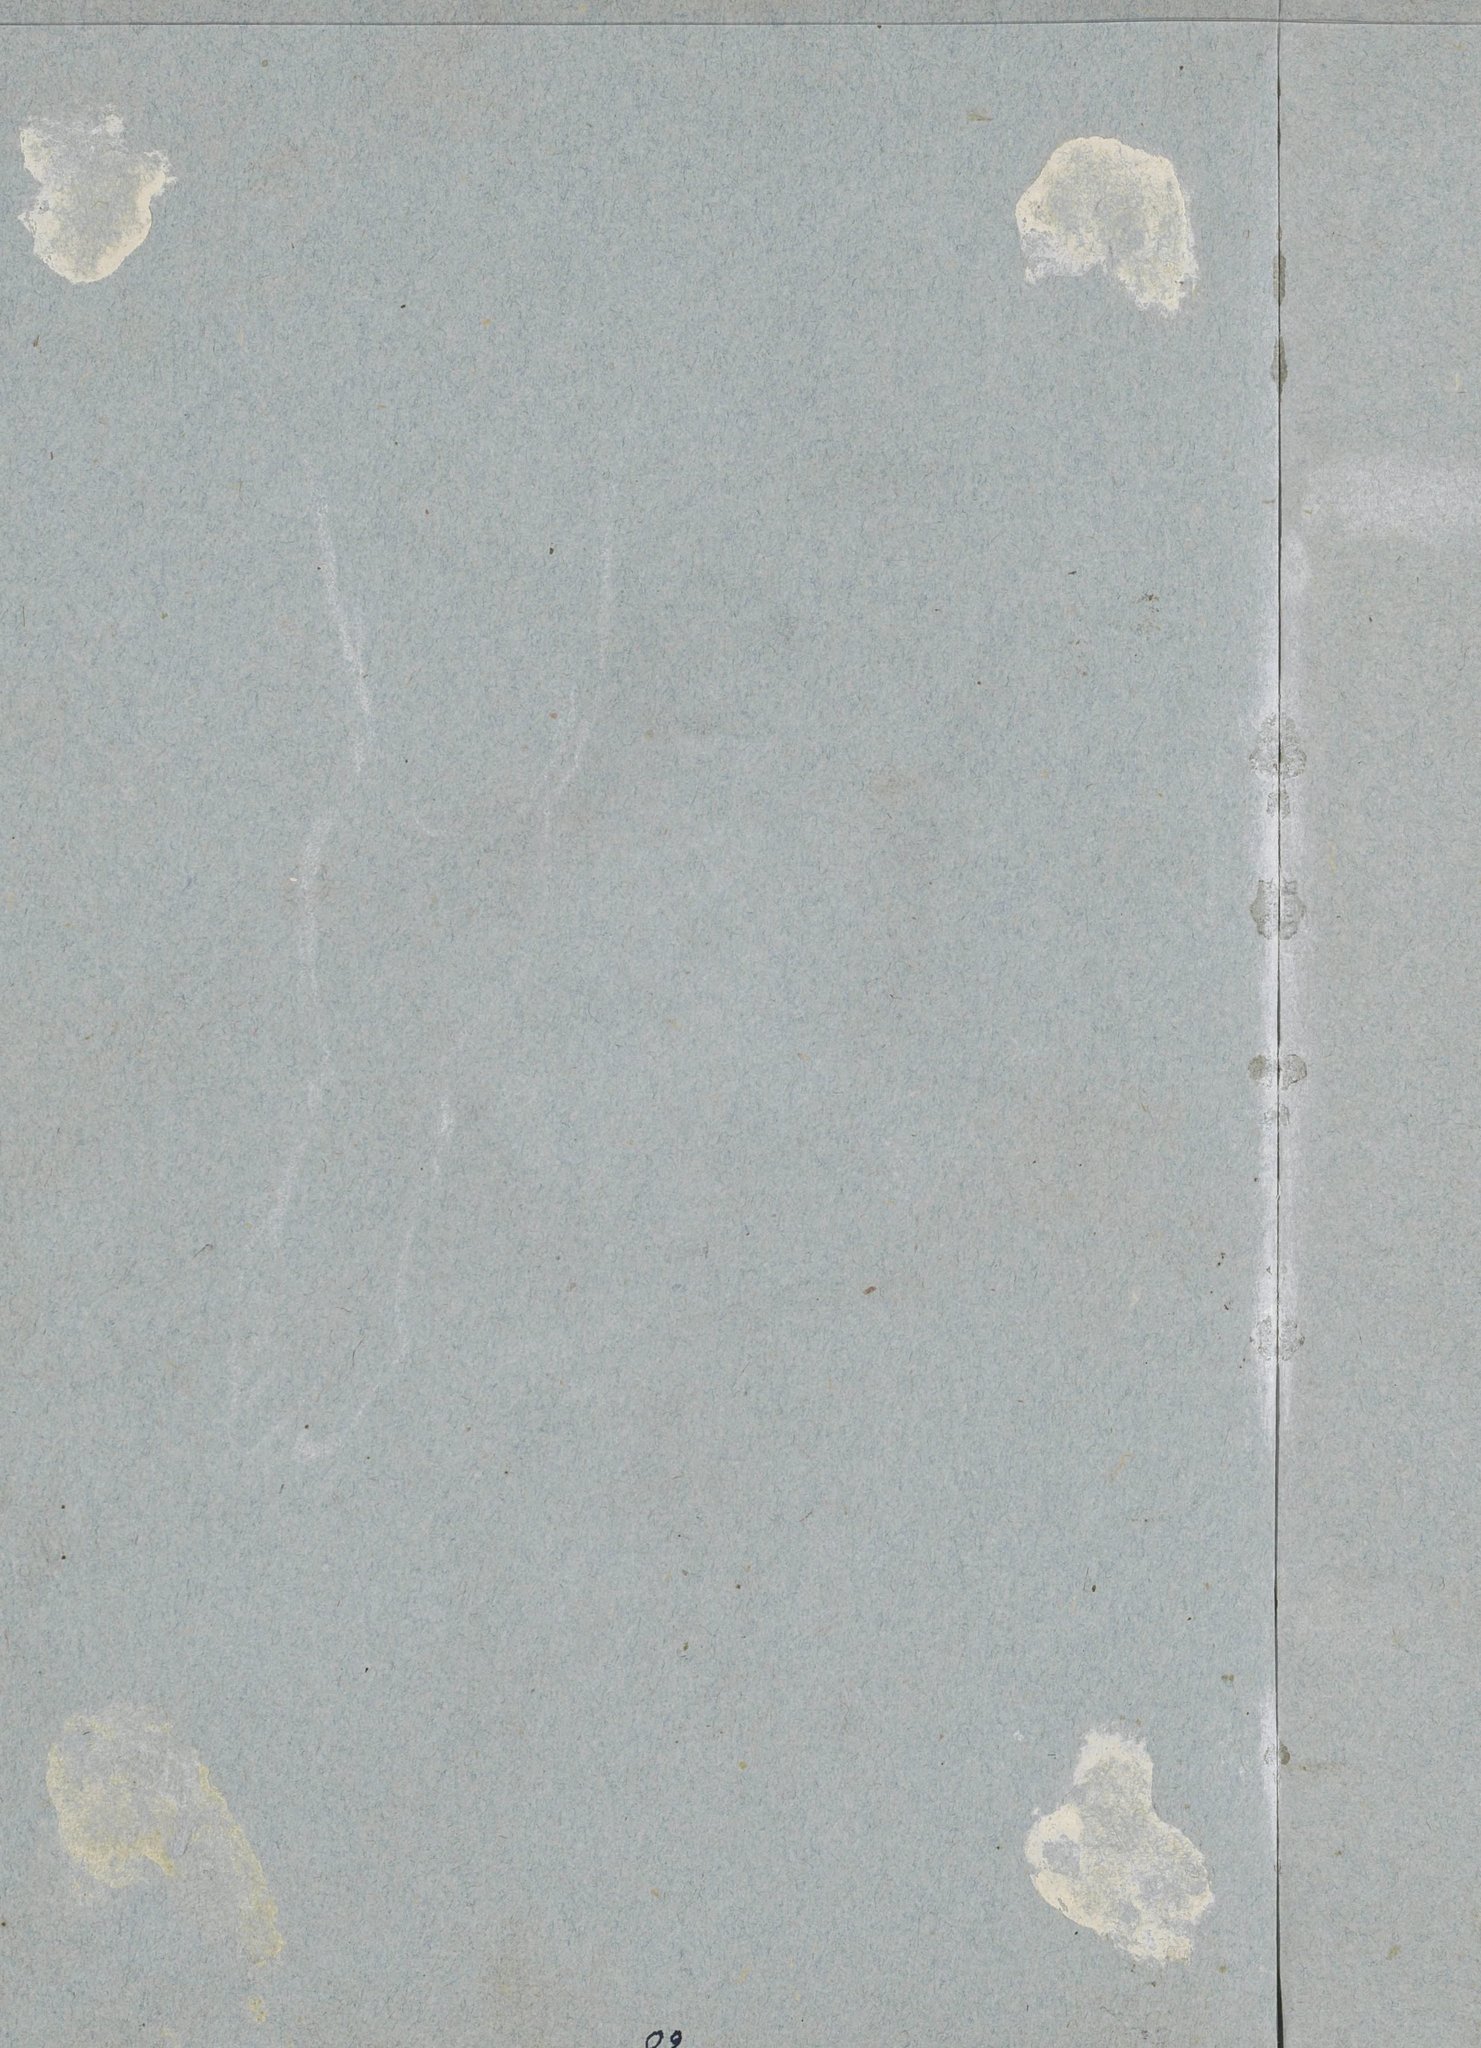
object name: sketchbook leaf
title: Onderbeen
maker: lorenzo baldissera tiepolo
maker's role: draughtsman, print maker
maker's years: 1736-1776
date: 1751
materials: chalk, paper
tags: lower leg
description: Deels doorgedrukt van bladzijde 103. Bladzijde 104 uit een schetsboek met 158 bladzijden.